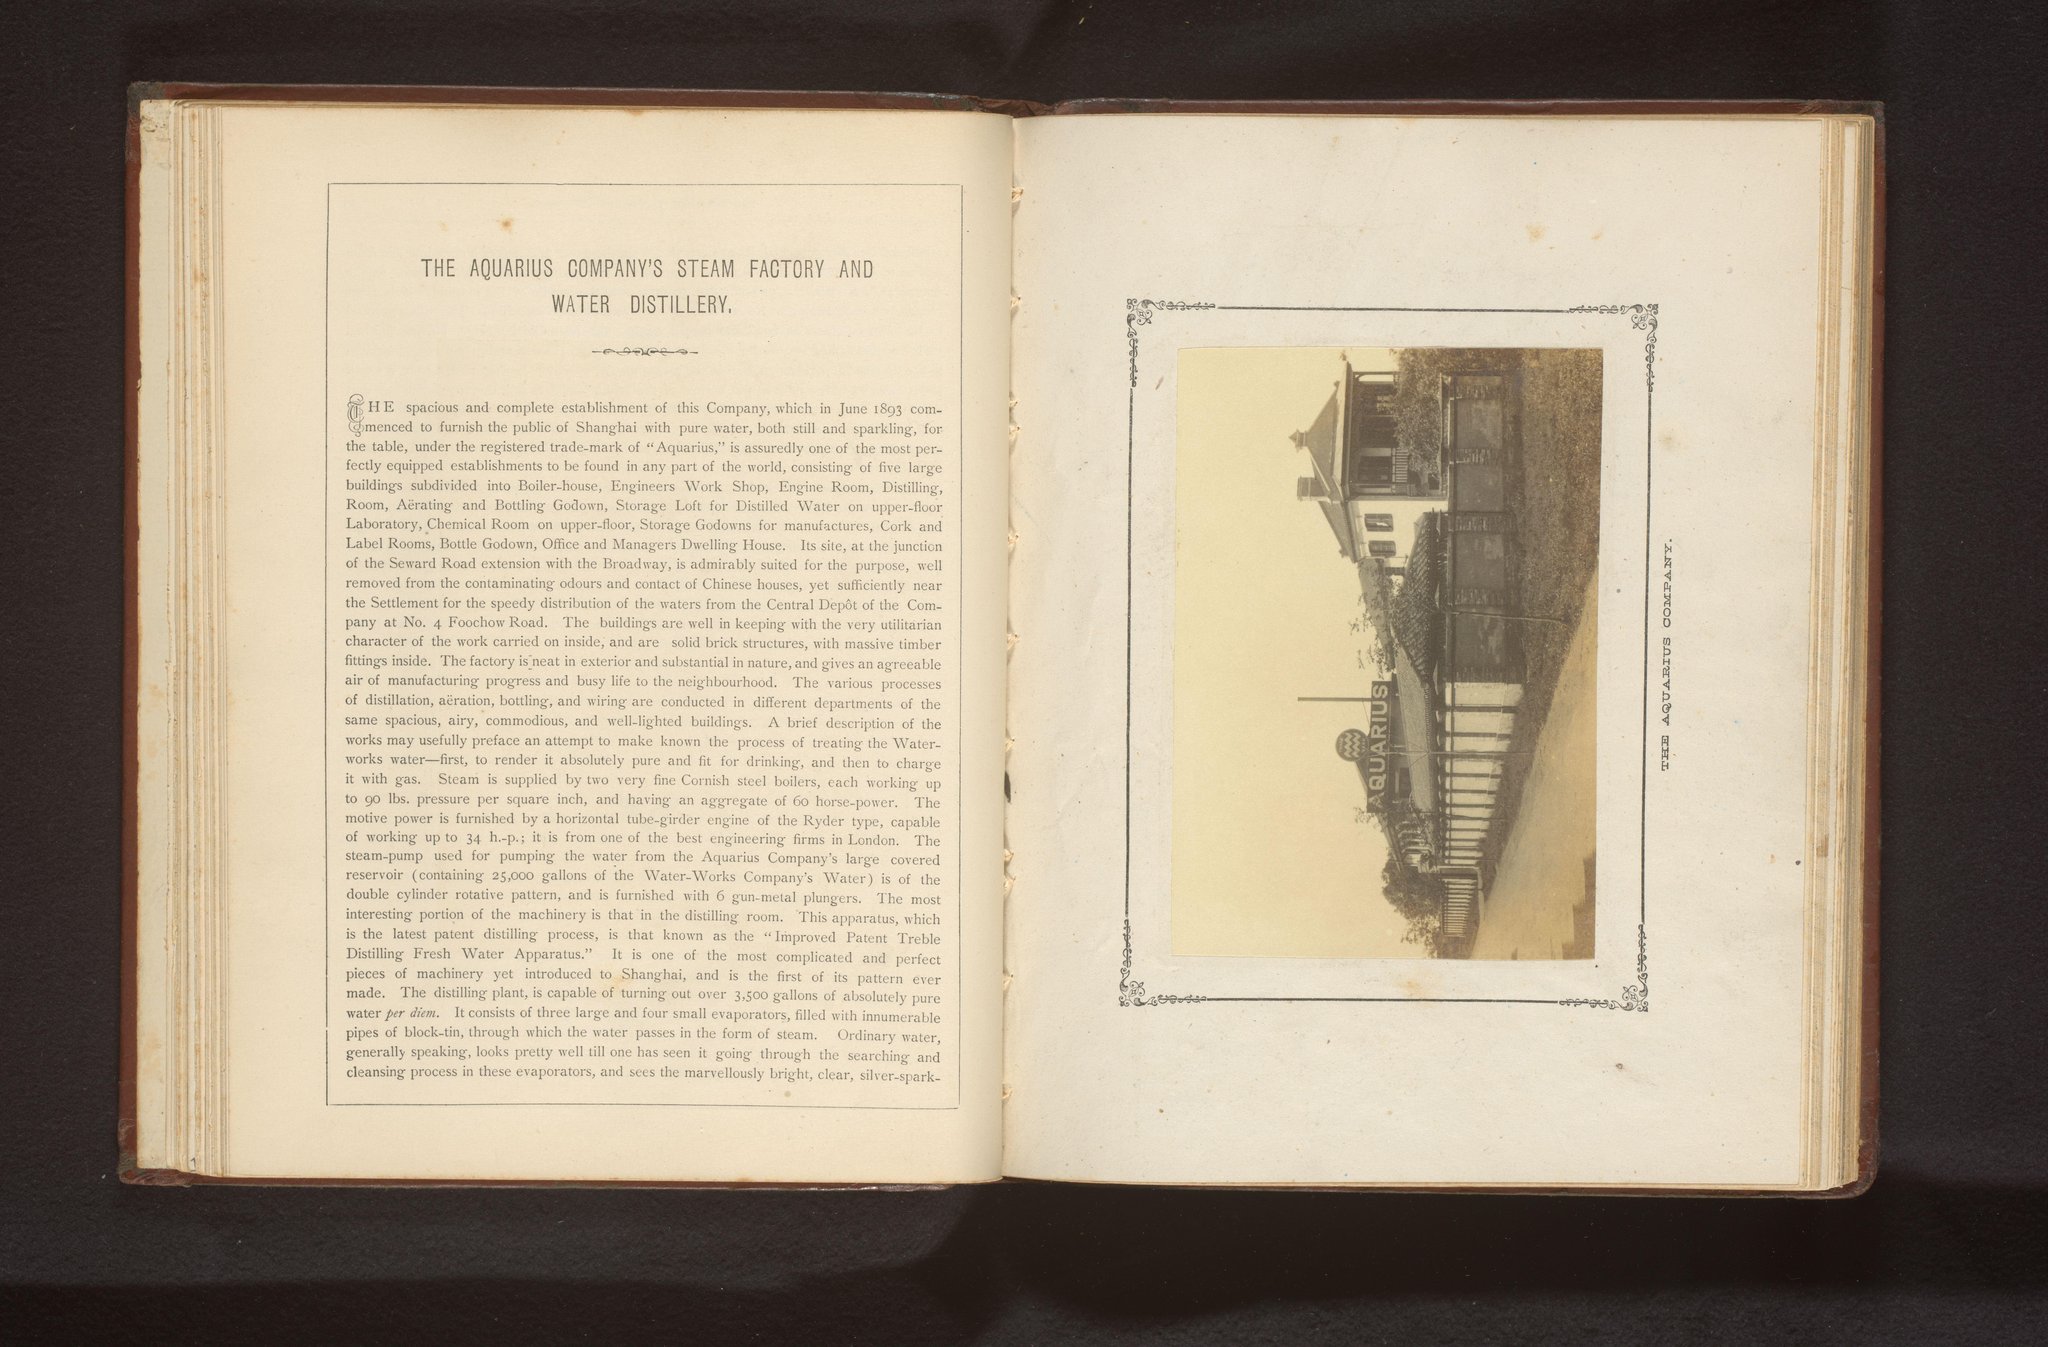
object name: photograph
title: The Aquarius Company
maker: Anonymous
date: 1884-1894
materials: photographic support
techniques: gelatin silver print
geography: shanghai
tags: trade-company